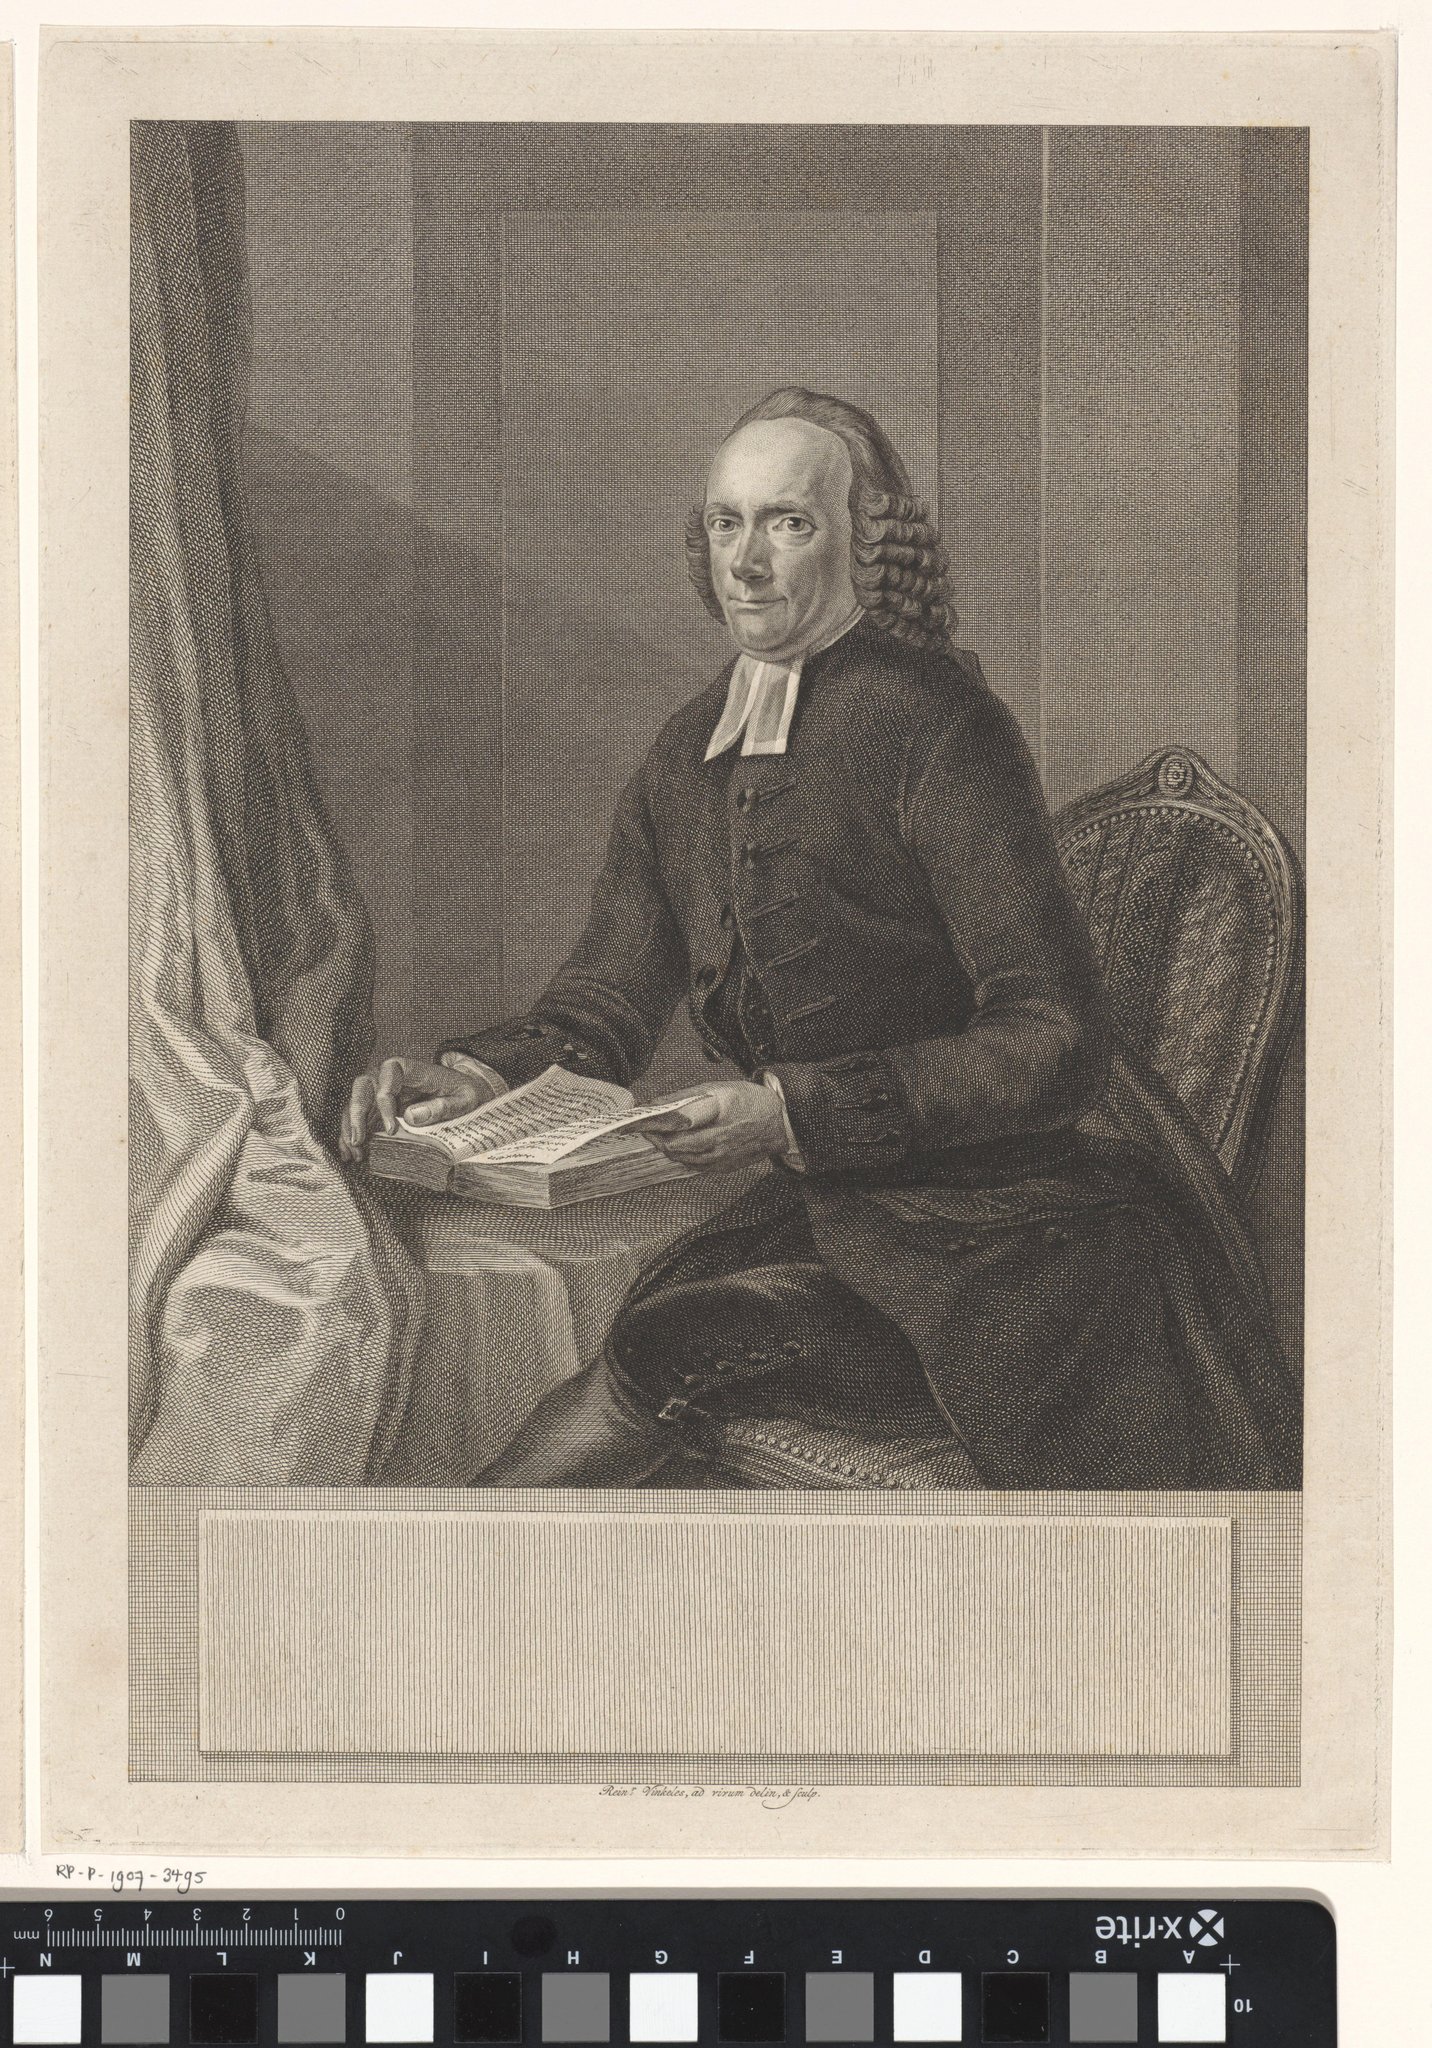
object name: print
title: Portret van Johan Diedrich Deiman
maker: reinier vinkeles (i)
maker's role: draughtsman, print maker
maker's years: 1741-1816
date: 1782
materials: paper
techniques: engraving, etching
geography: amsterdam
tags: predikant, johan diederich deiman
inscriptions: collector's mark: Lugt 2228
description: Portret van Johan Diedrich Deiman, Lutherse predikant te Amsterdam, zittende op een stoel met voor hem een opengeslagen bijbel.